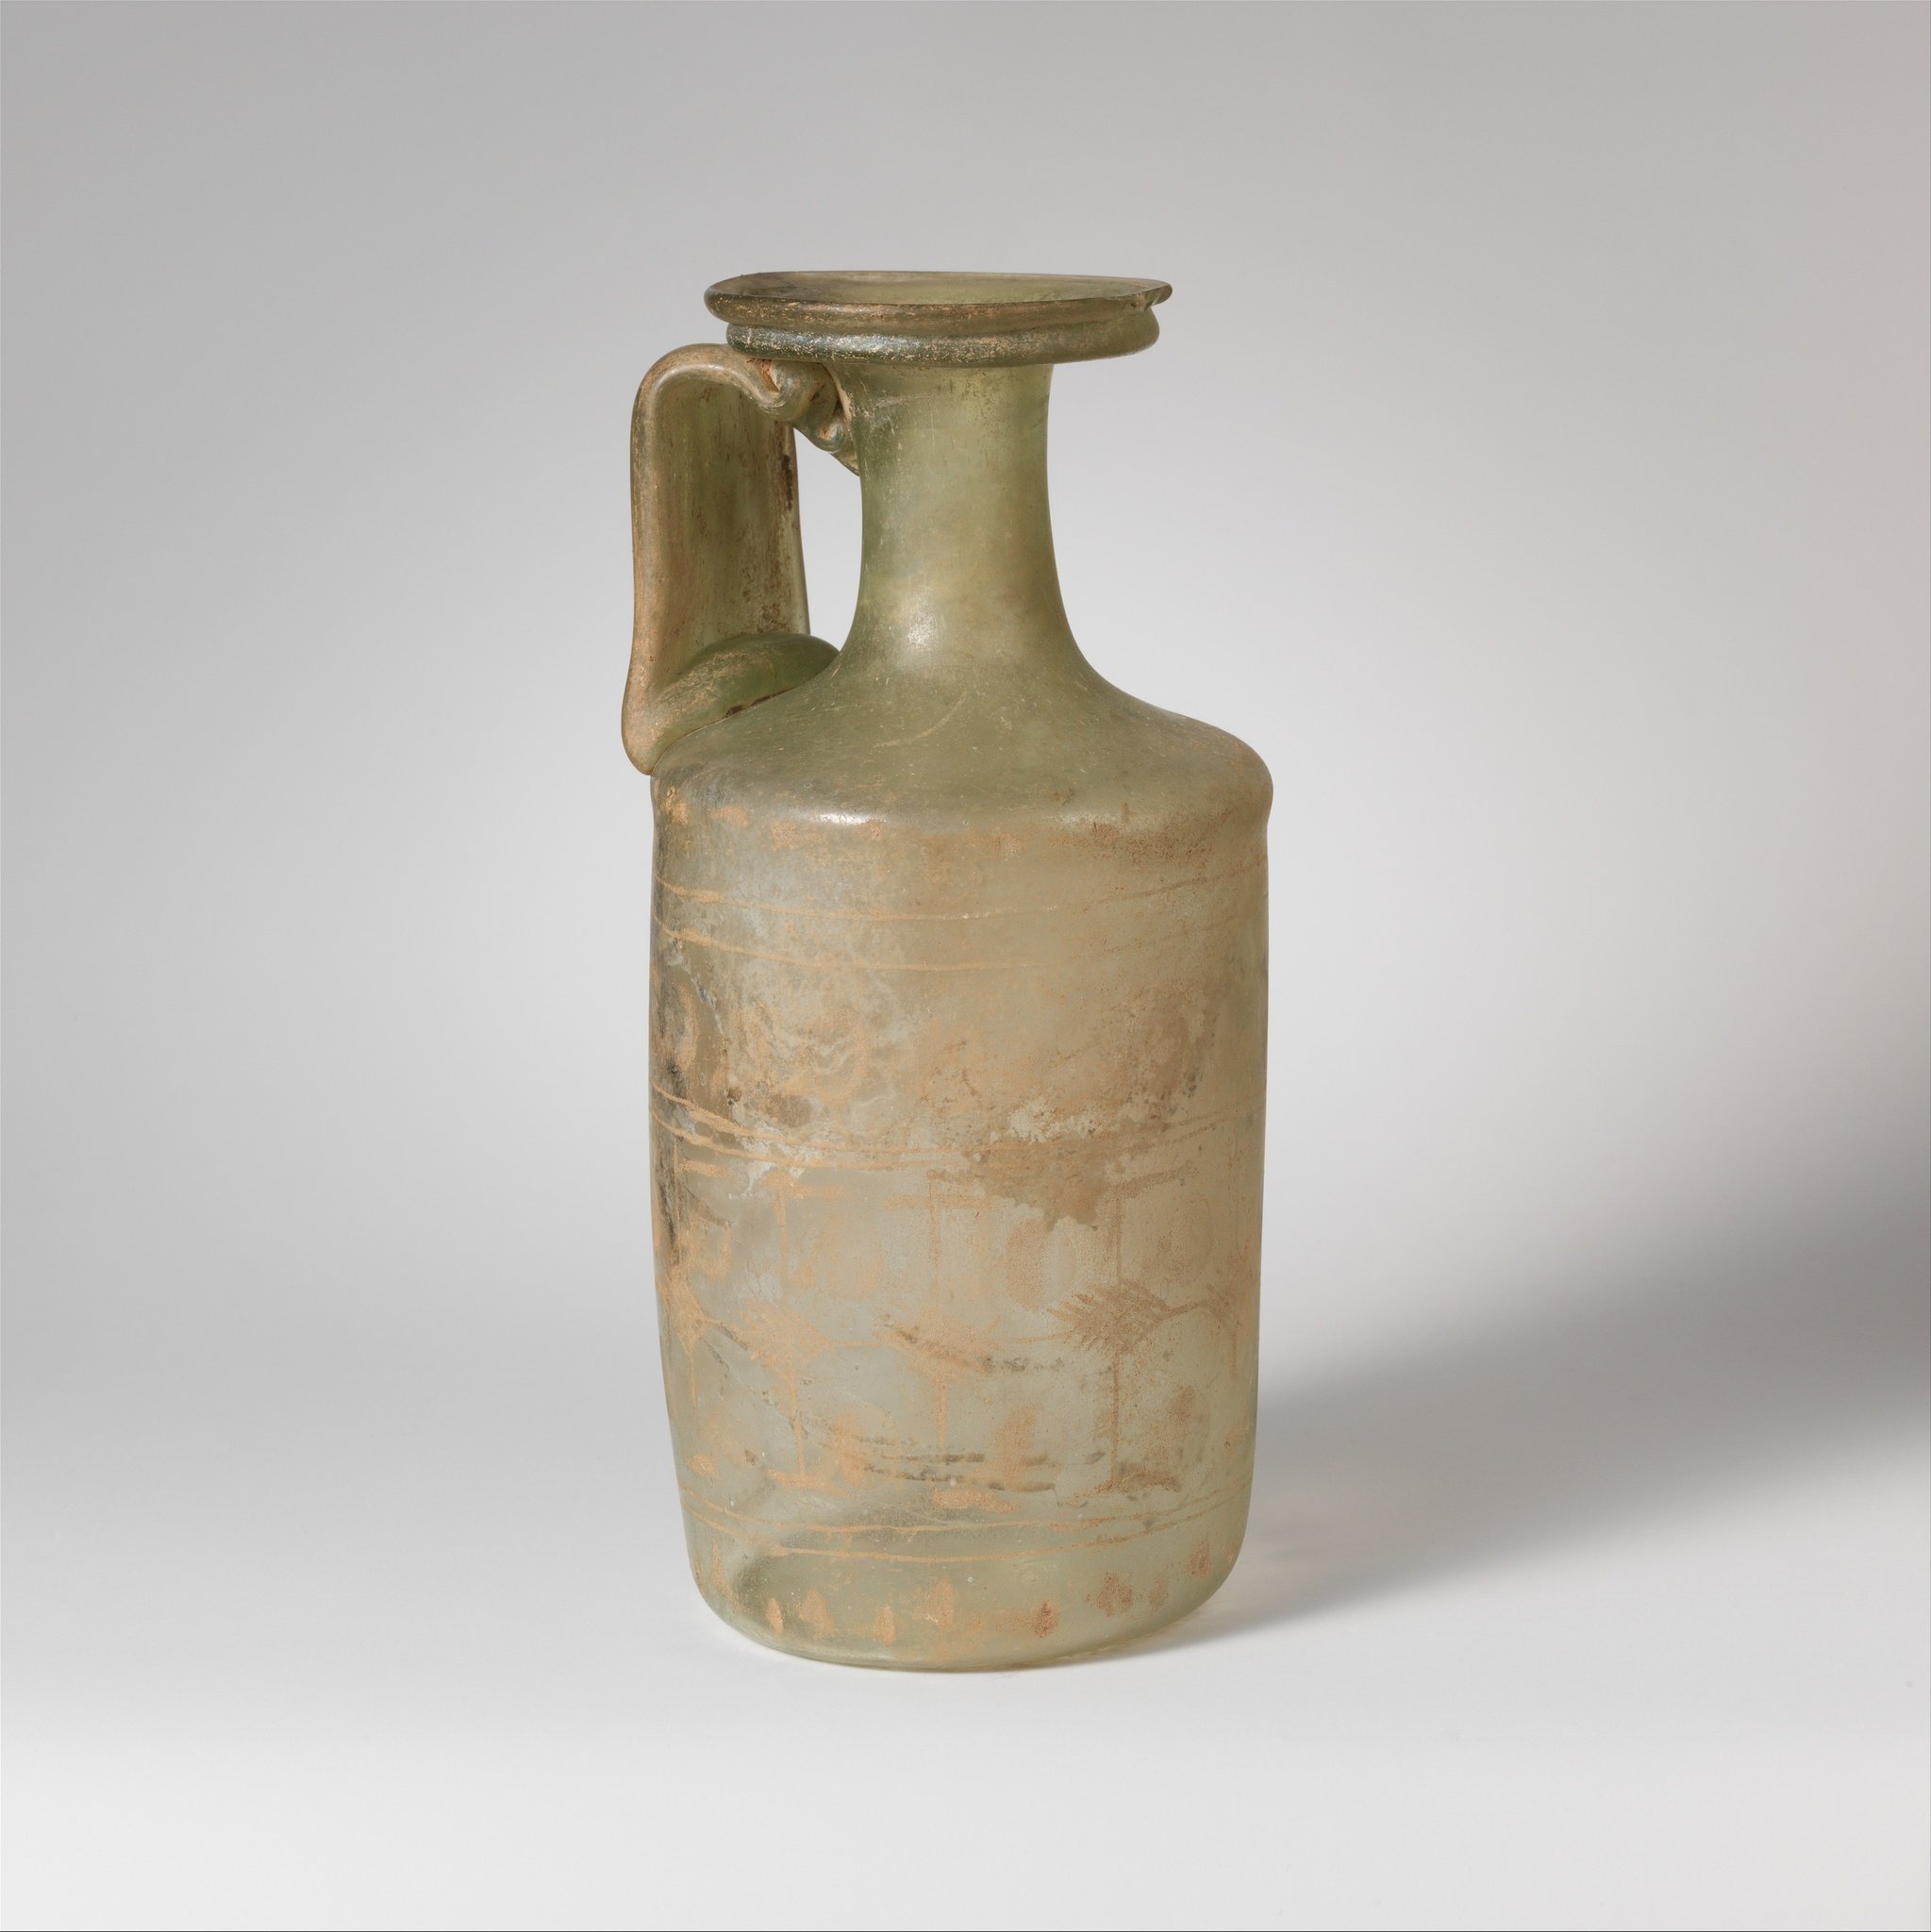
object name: bottle, cylindrical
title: Glass cylindrical bottle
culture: roman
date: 301-400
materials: glass